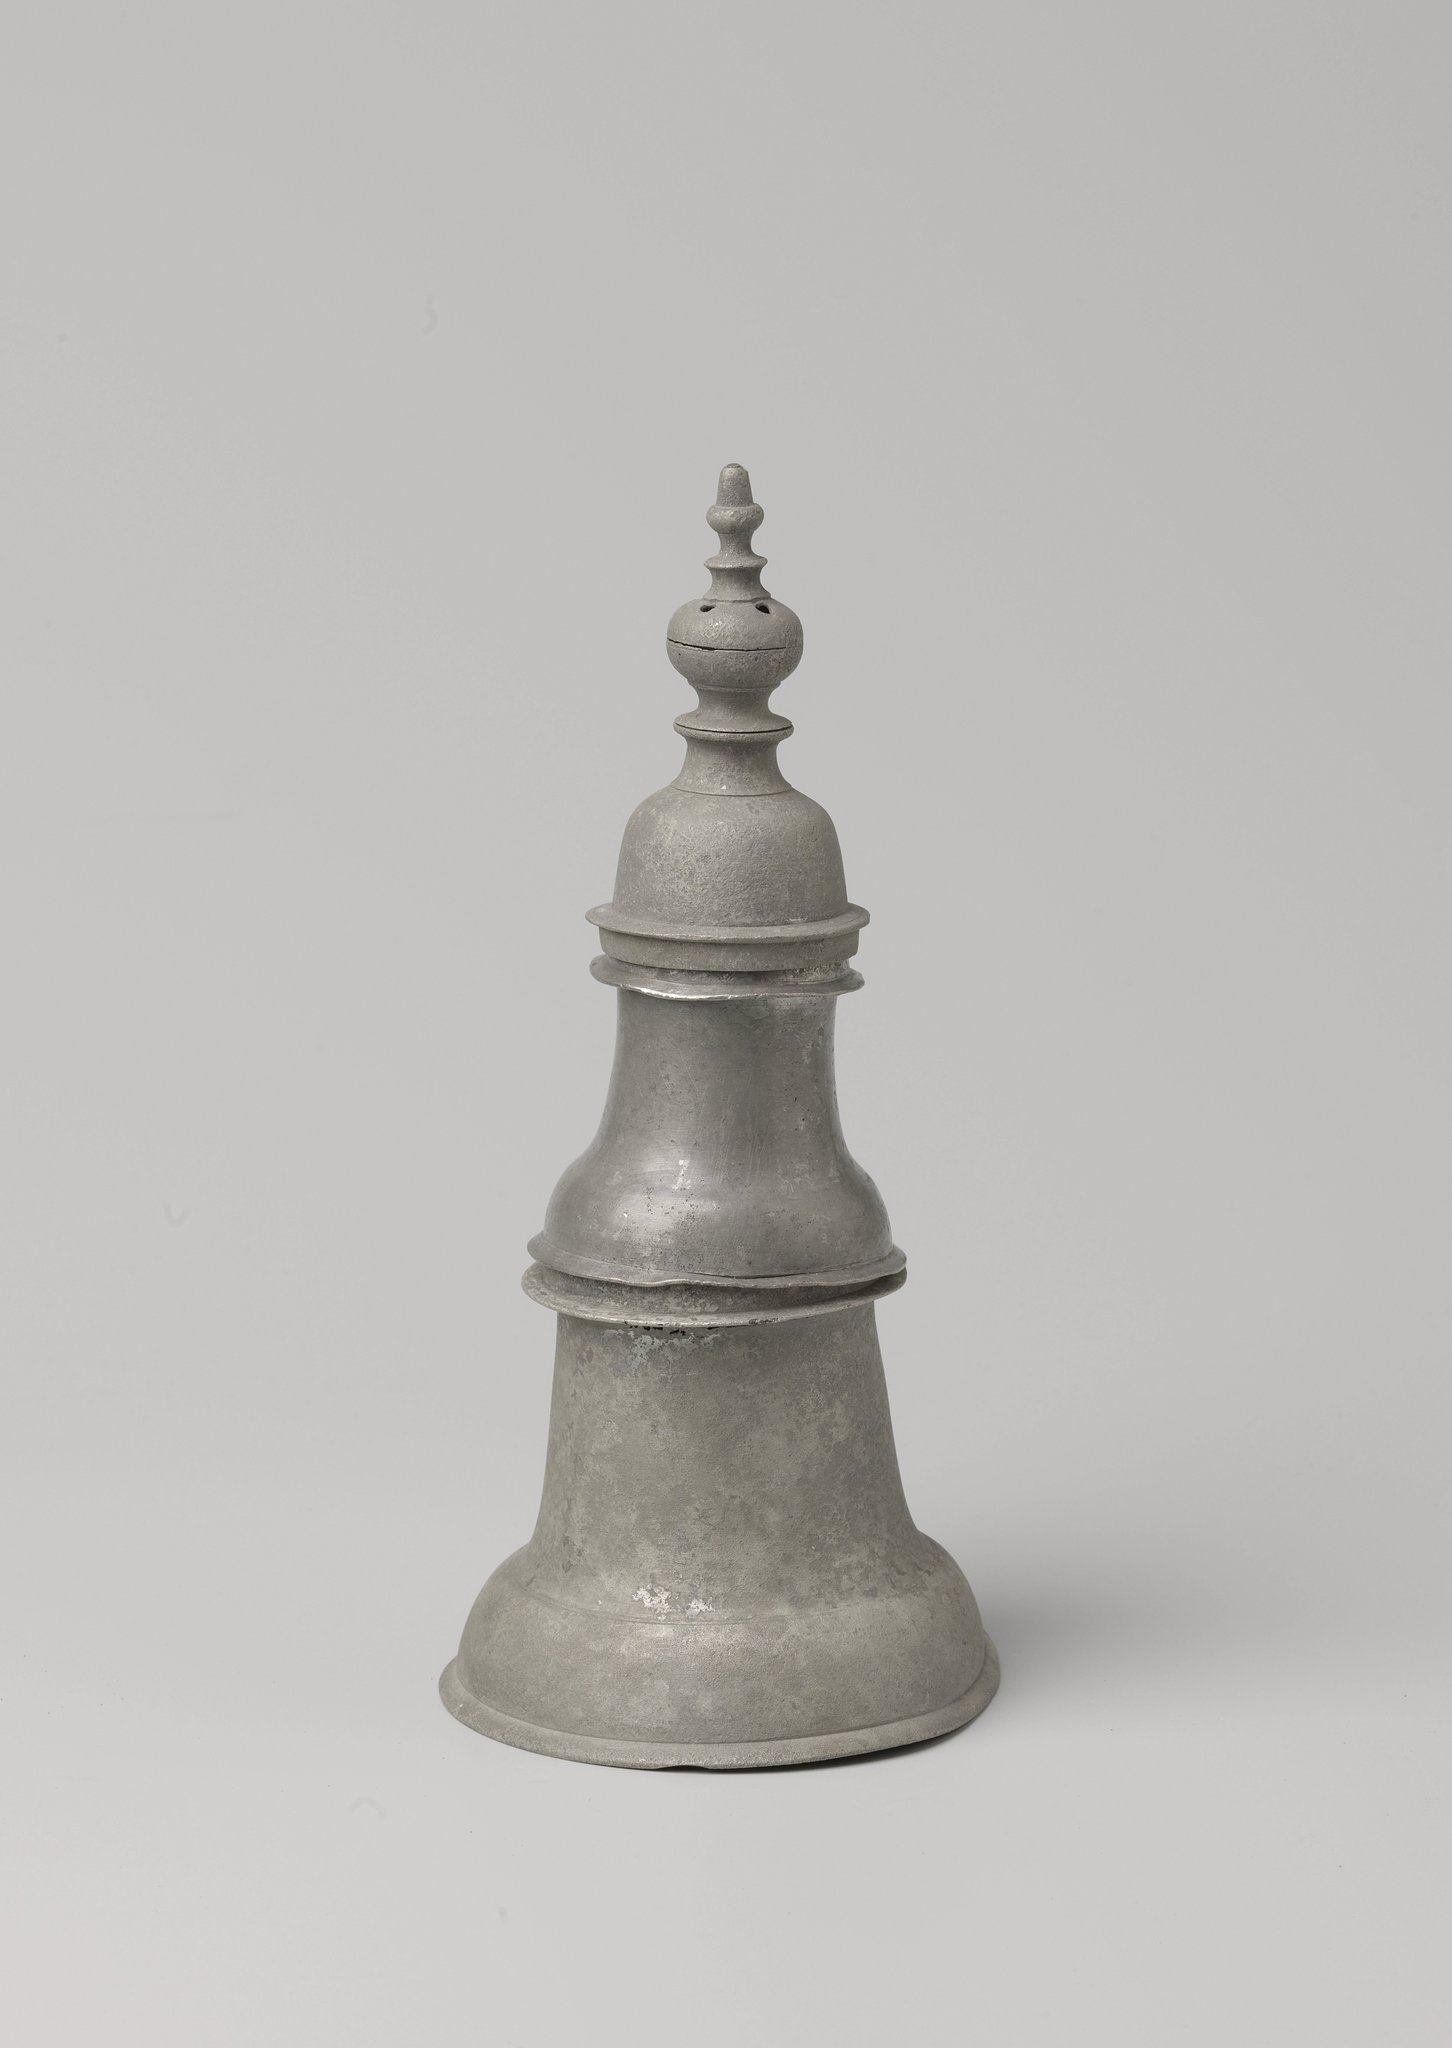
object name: salt condiment vessel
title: Onderstuk van een zoutvat van tin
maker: Anonymous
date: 1590-1596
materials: tin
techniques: casting, silvering, soldering, turning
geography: england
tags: willem barendsz., jacob van heemskerck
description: Onderstuk van een zoutvat van tin. Aan de bovenzijde een holte voor zout of kruiden. Er zijn sporen van verzilvering aanwezig. Vormt samen met een midden- en een bovenstuk een zoutvat.